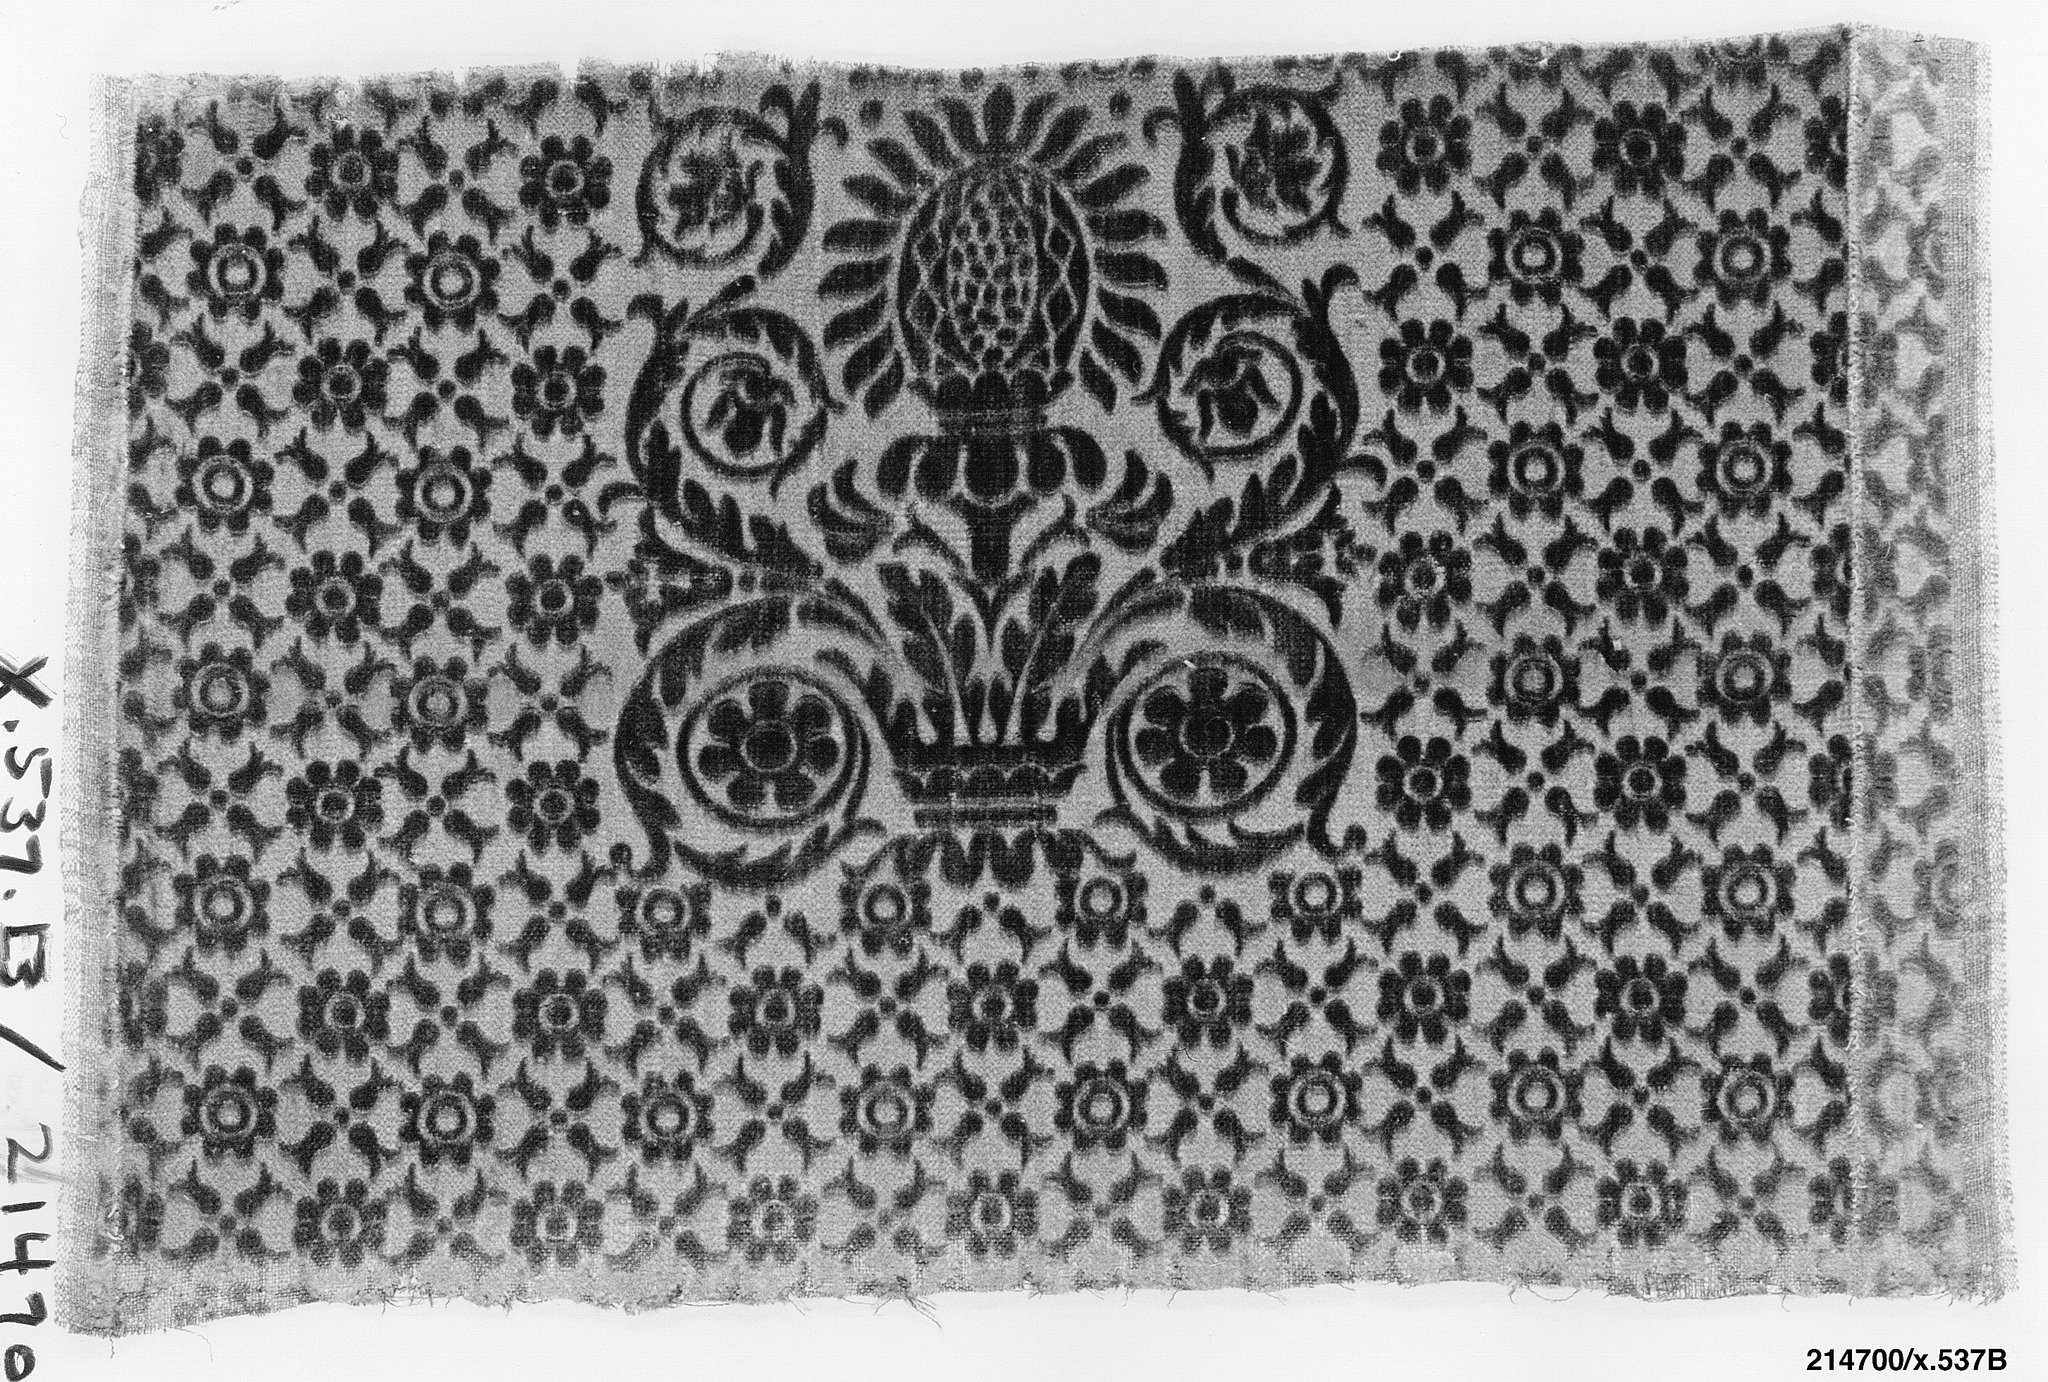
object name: breadth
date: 1801-1833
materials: wool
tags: flowers